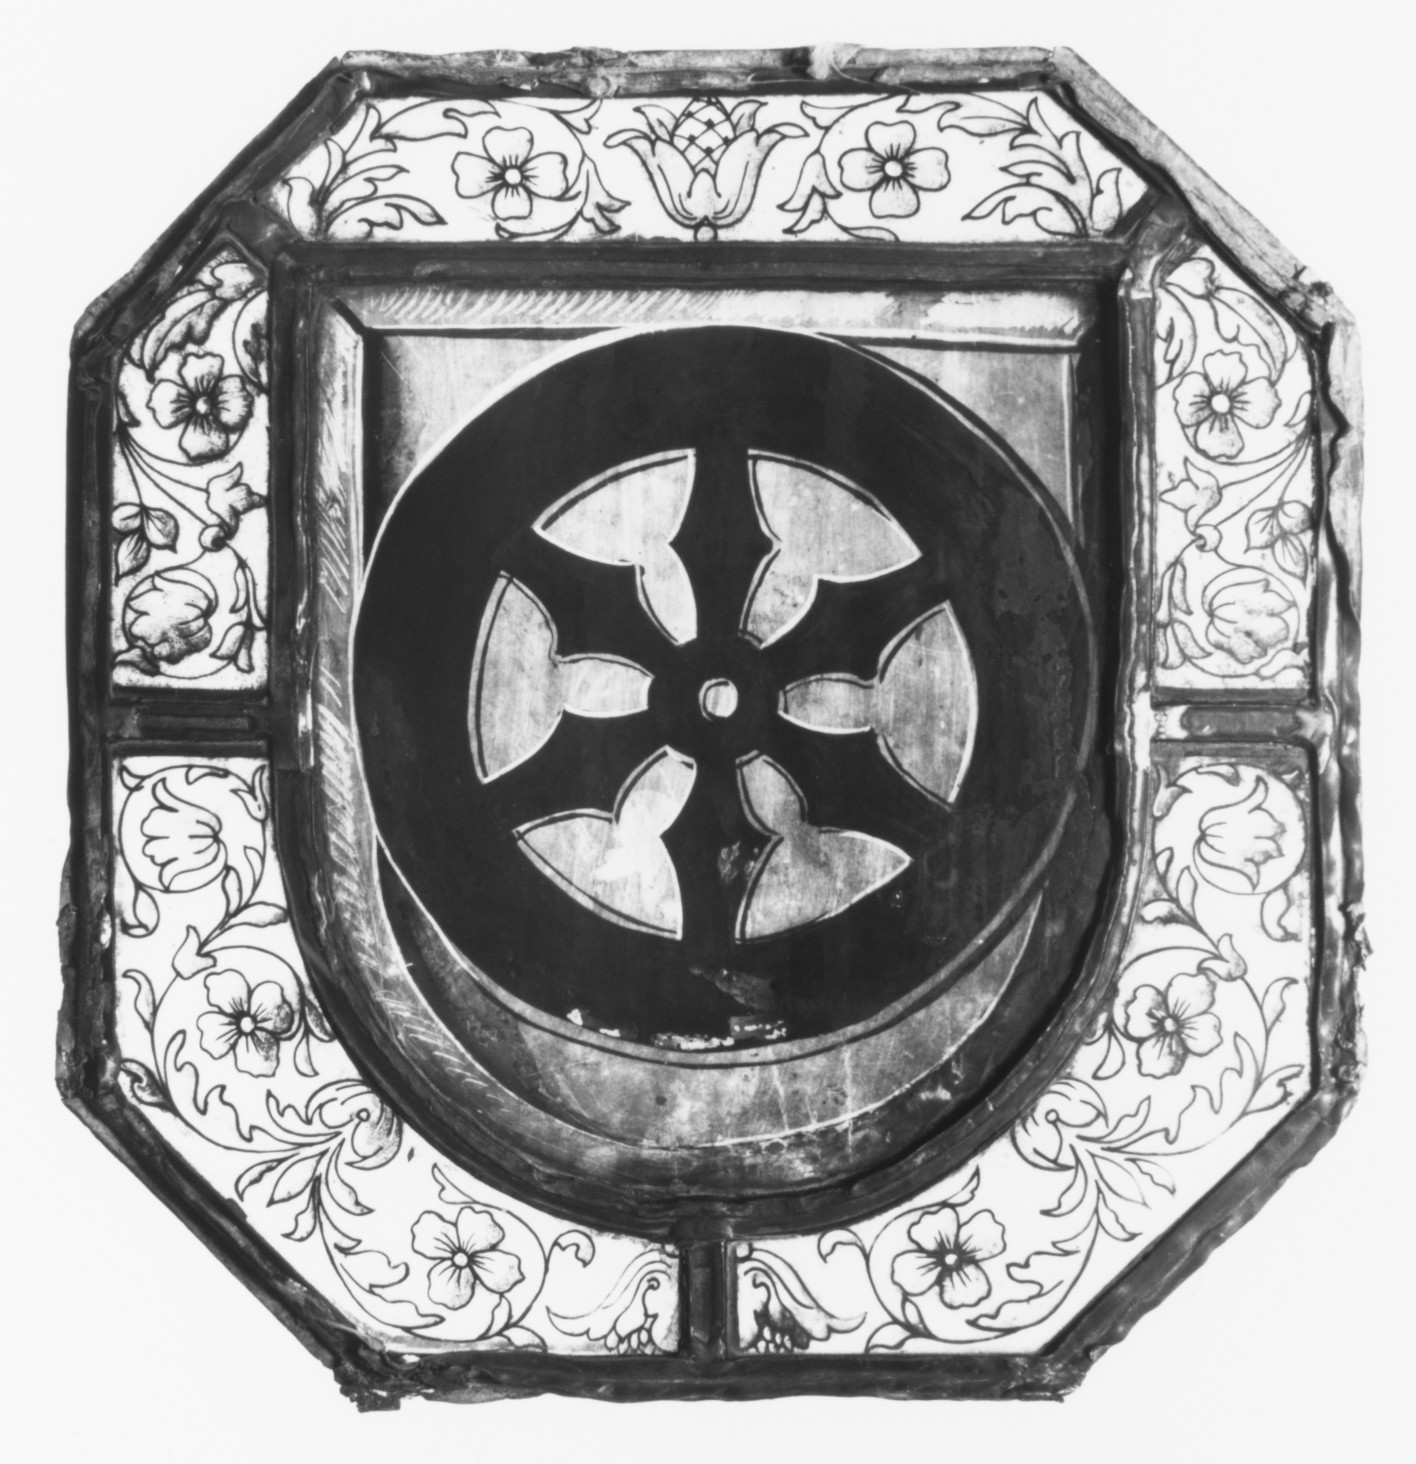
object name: armorial panel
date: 1601-1700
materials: glass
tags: flowers,leaves